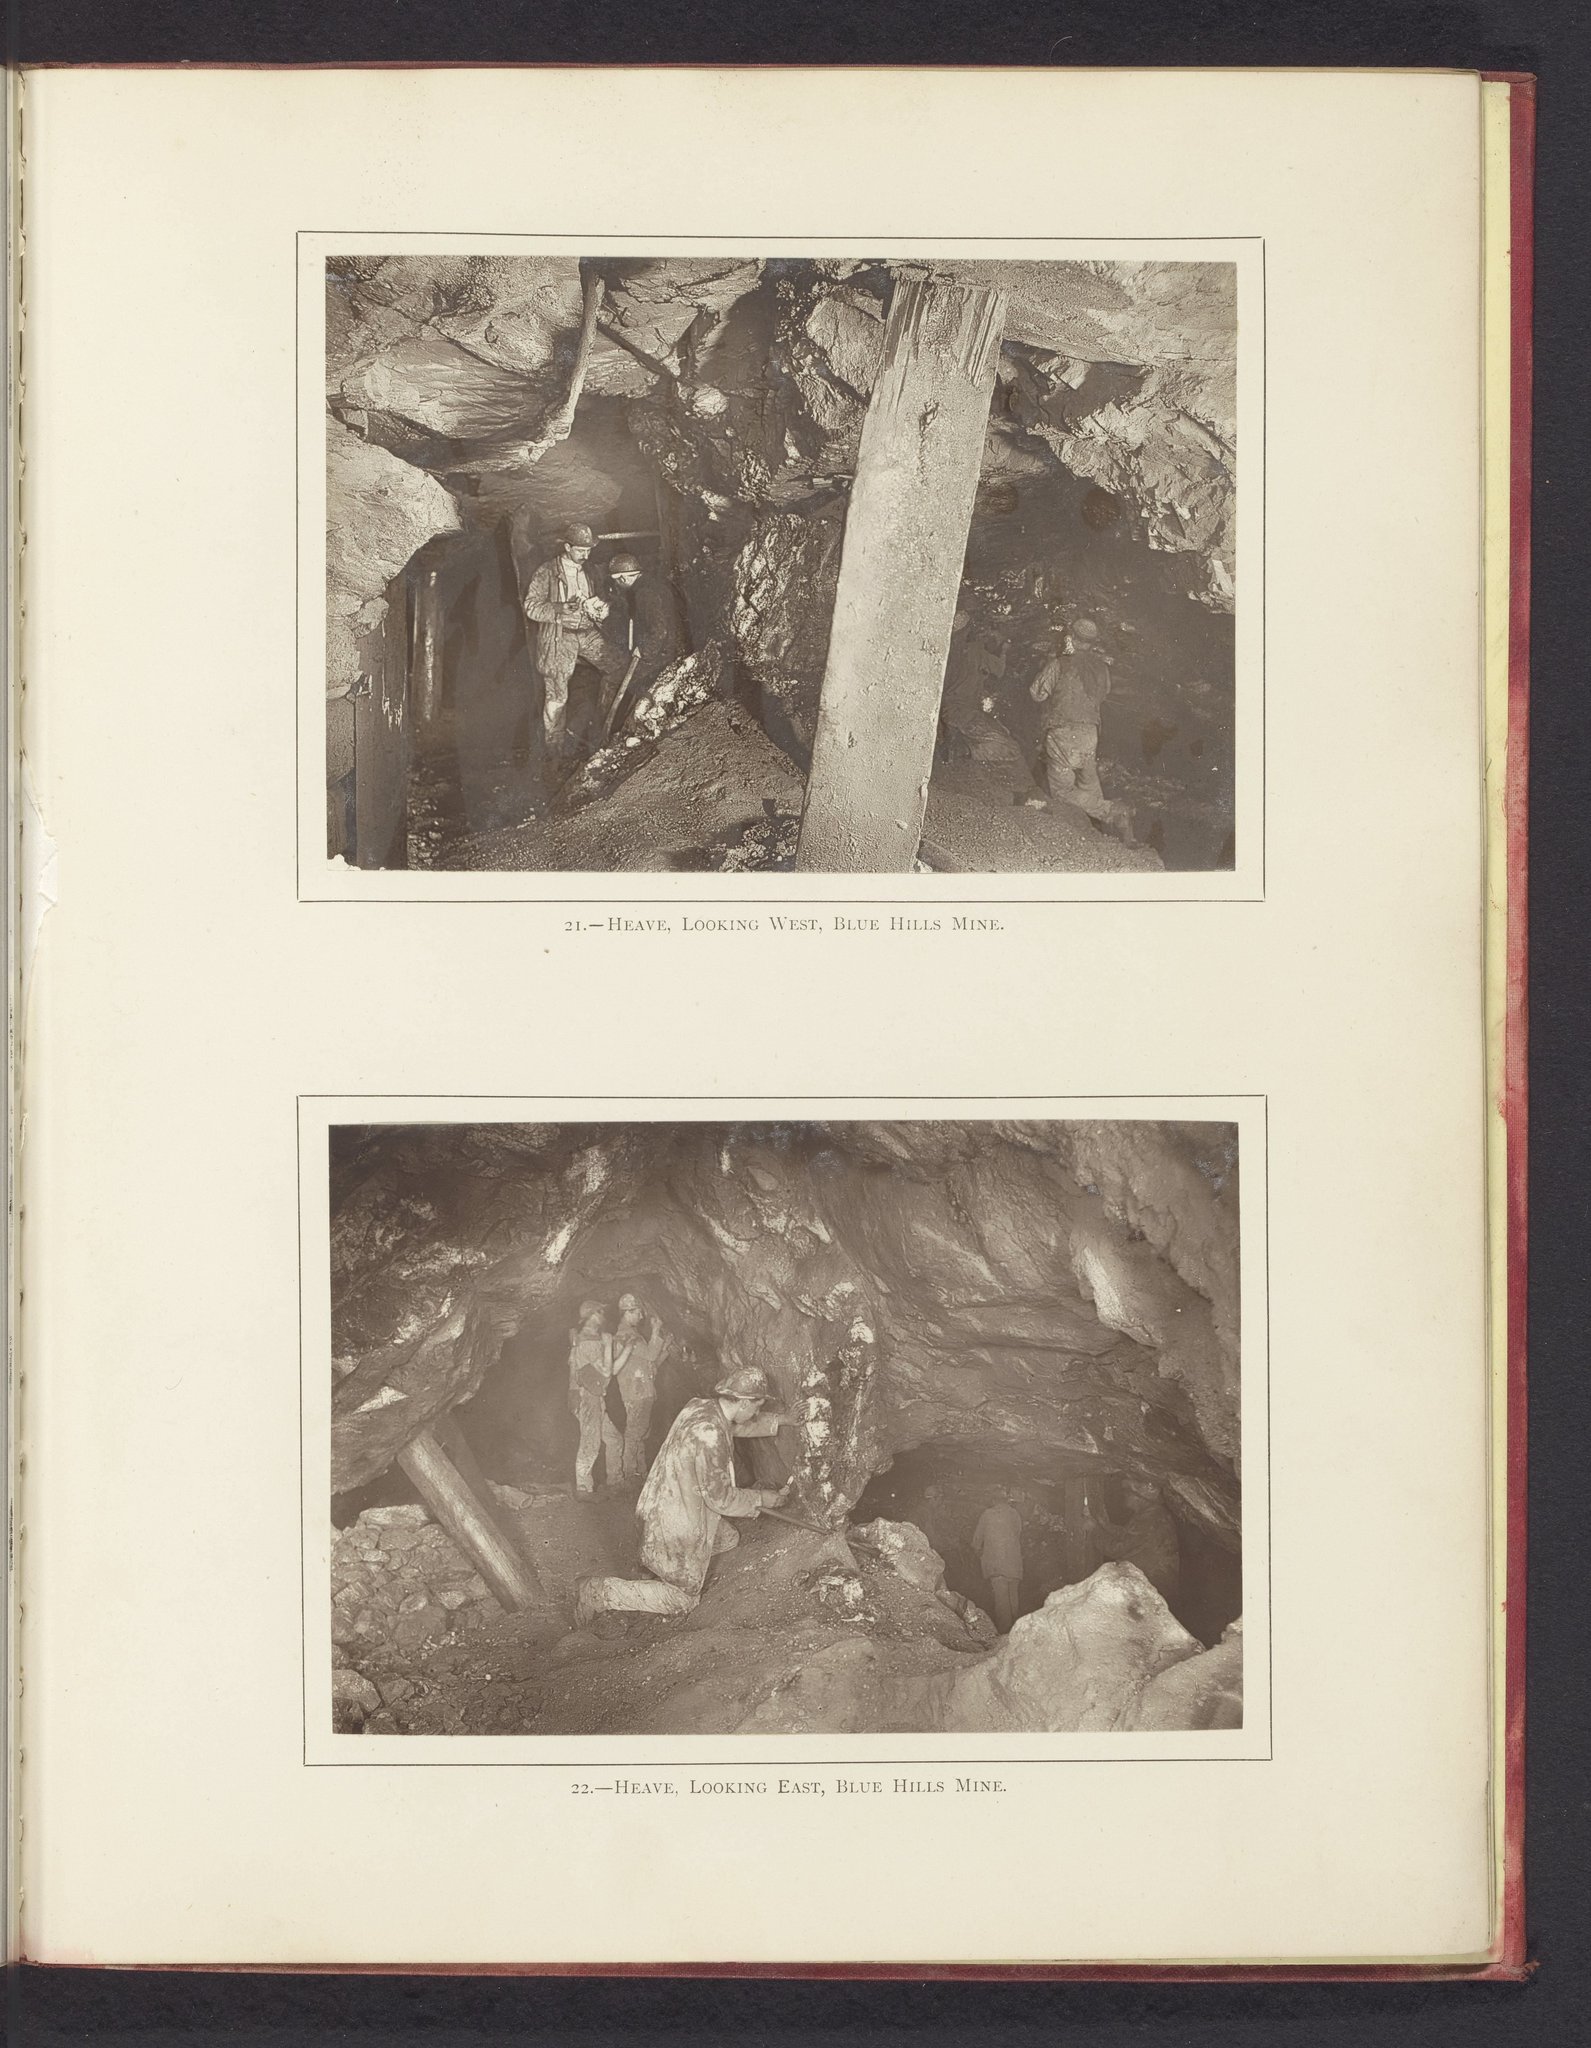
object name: page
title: Heave, looking west, Blue Hills Mine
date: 1893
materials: paper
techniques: woodburytype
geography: united kingdom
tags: miner, shafts and galleries (of a mine), beam, log of wood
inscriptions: number: ‘22.’, number: ‘21.’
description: Boven een pijler met op de voorgrond een houten stut, onder mijnwerkers in een pijler.